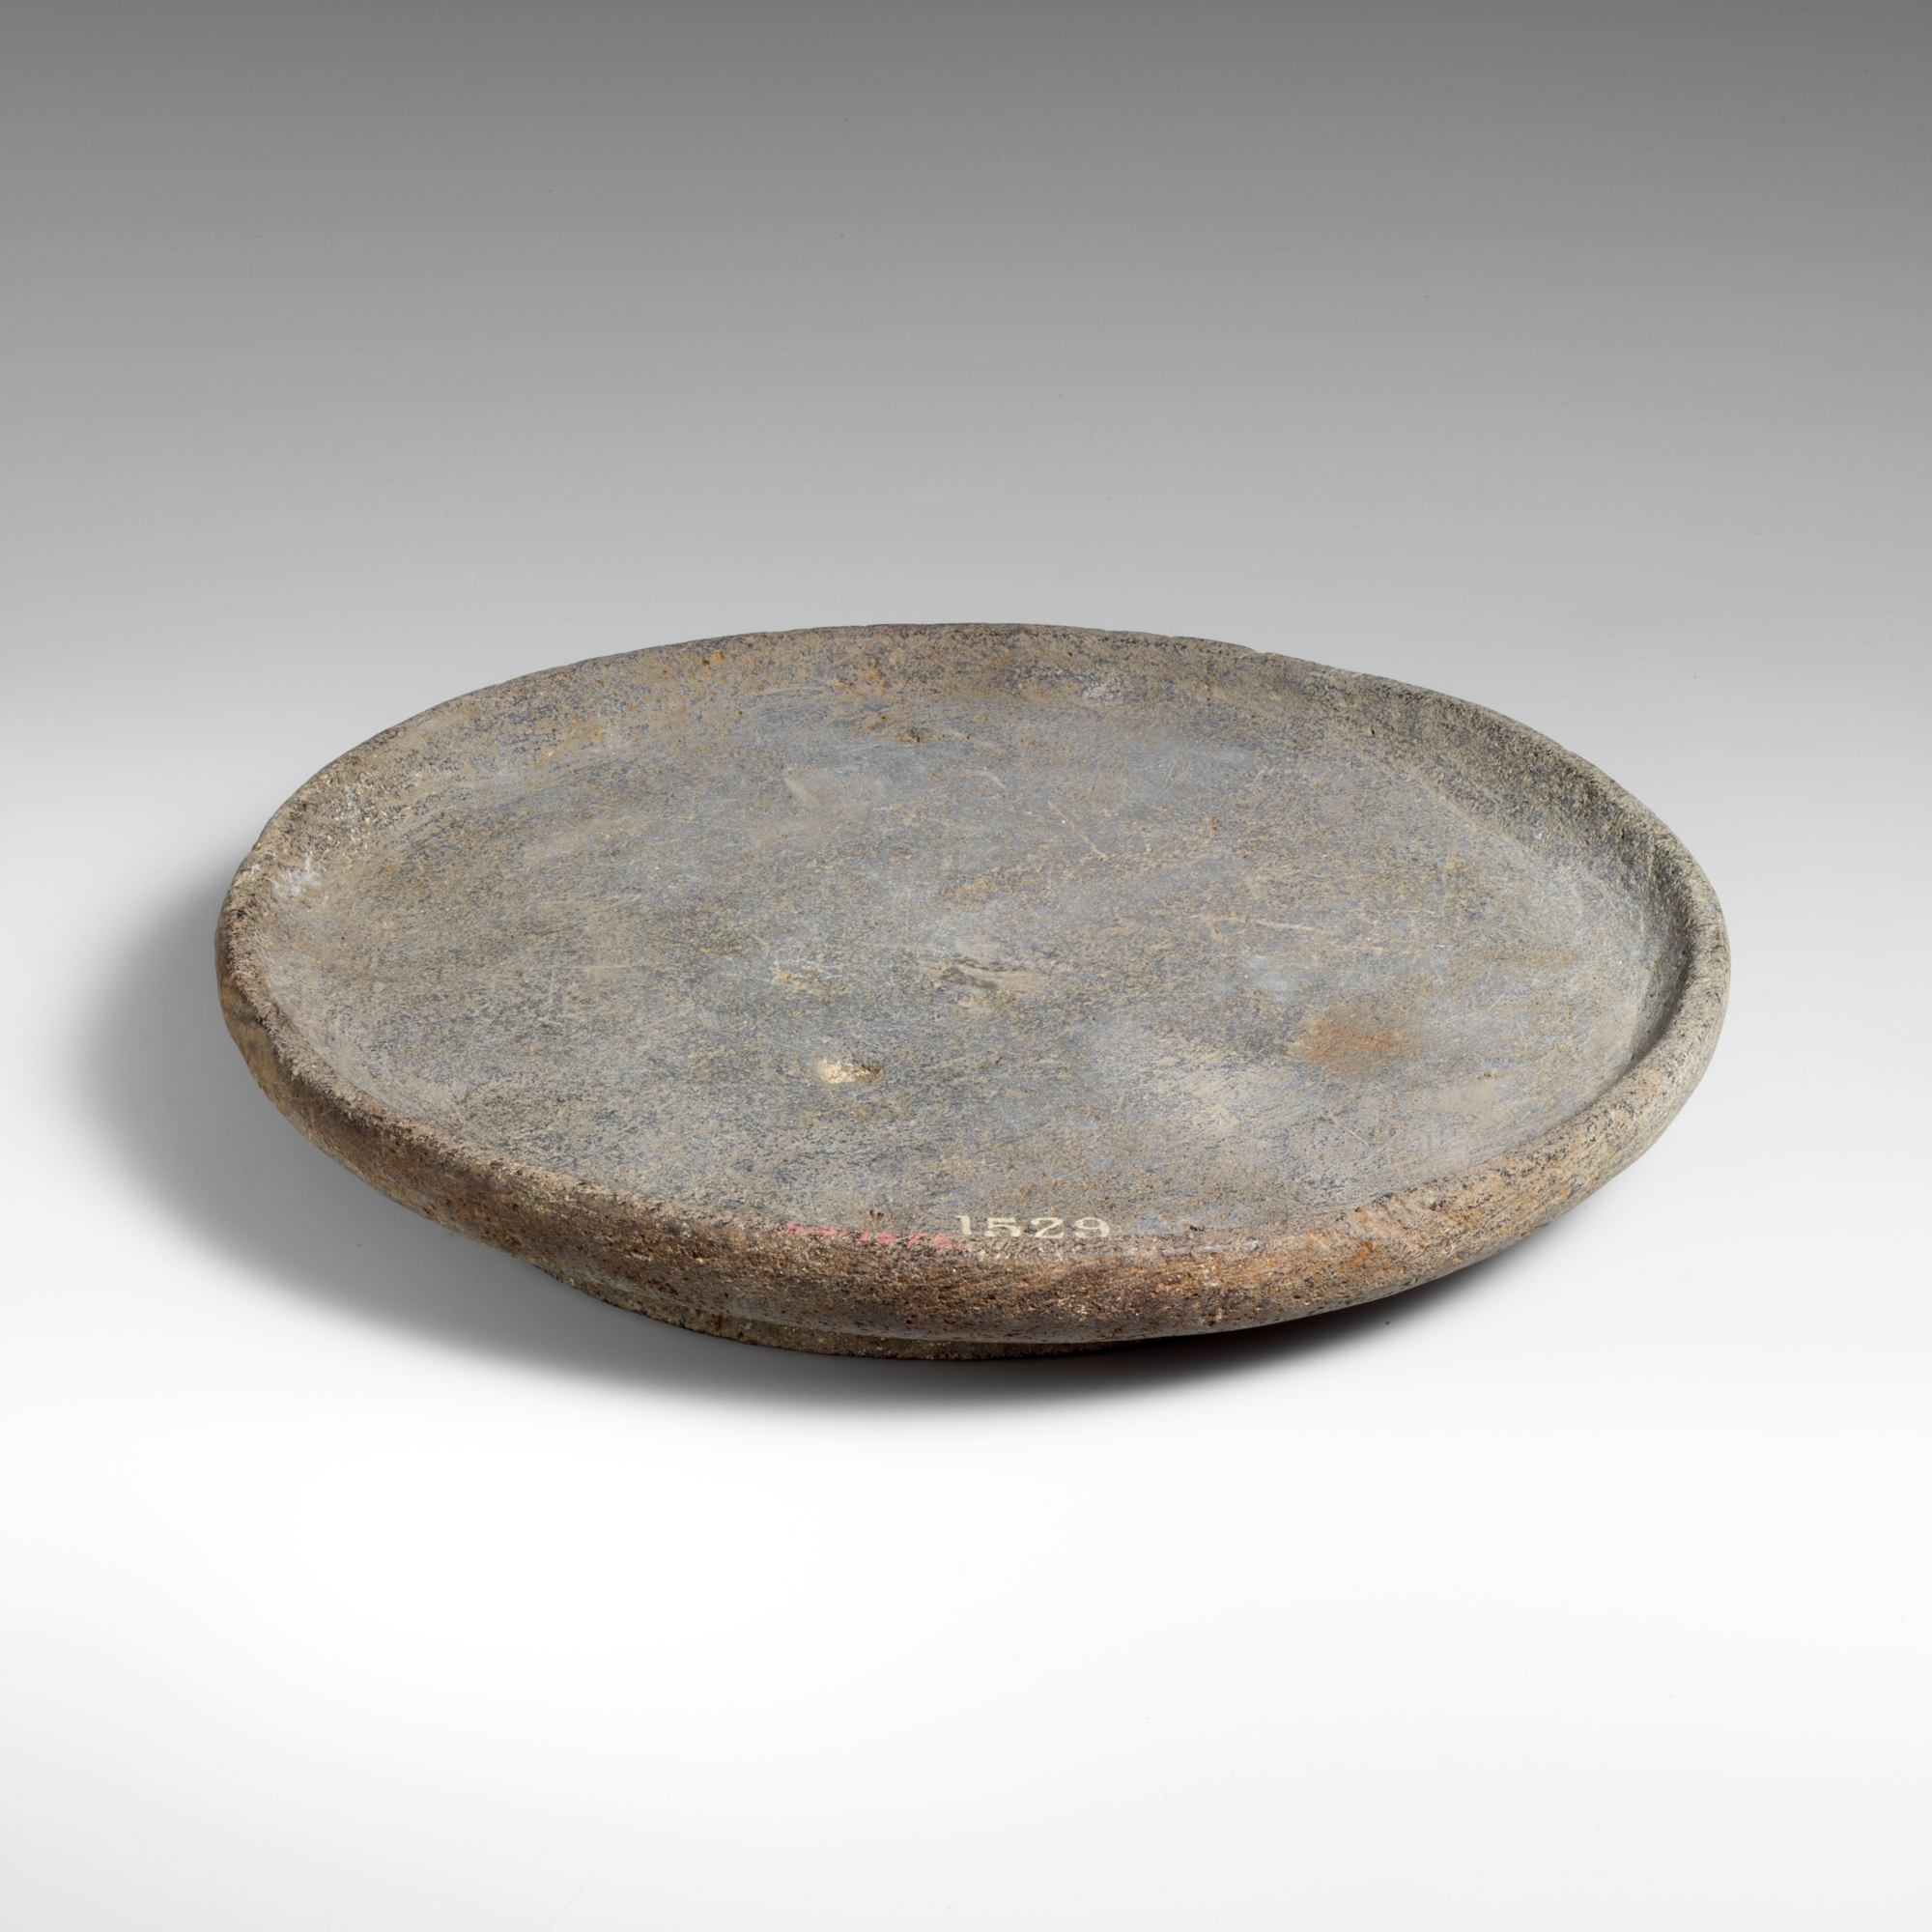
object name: plate or palette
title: Basalt mortar or plate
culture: cypriot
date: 1600-1050 BCE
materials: stone